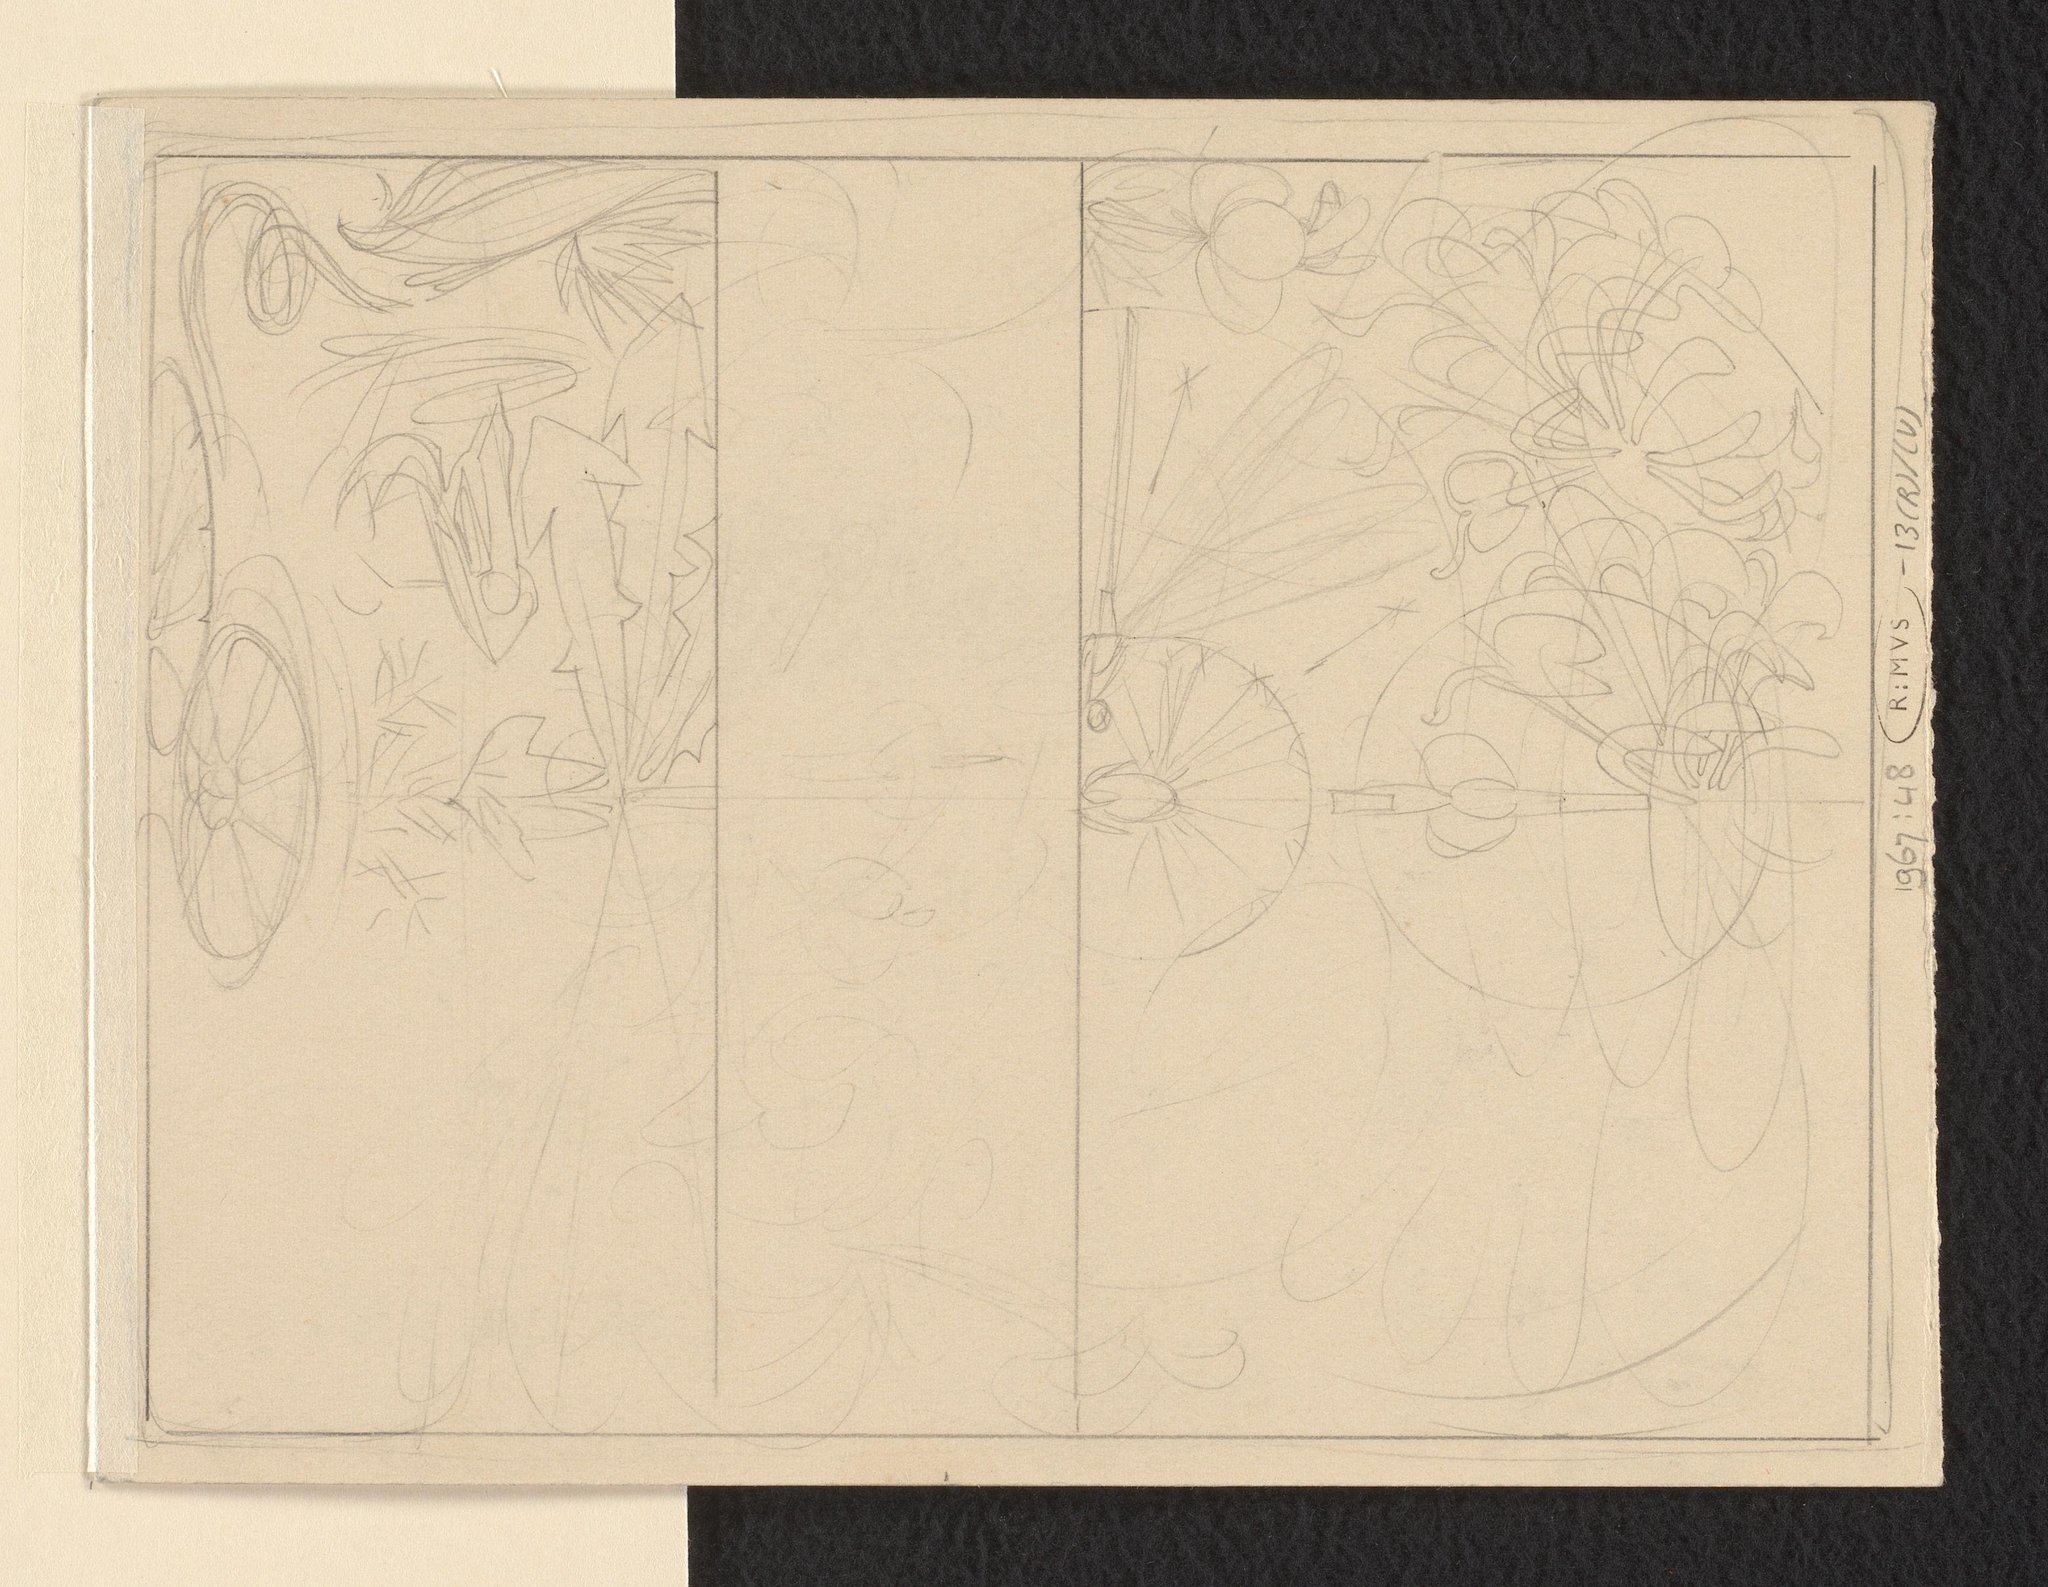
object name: titelblad, titelpagina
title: Ontwerp voor een titelpagina voor: Frederik van Eeden, De kleine Johannes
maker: edzard koning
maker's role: draughtsman, print maker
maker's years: 1869-1954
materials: paper, pencil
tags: flowers, tailless amphibians: frog, insects: dragon-fly, (van eeden, de kleine johannes) specific works of literature (with author, title)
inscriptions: collector's mark: Lugt 2228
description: Ontwerp voor: Eeden, Frederik van. De kleine Johannes. Den Haag: Mouton & Co., 1898. Niet gebruikt in de definitieve uitgave.